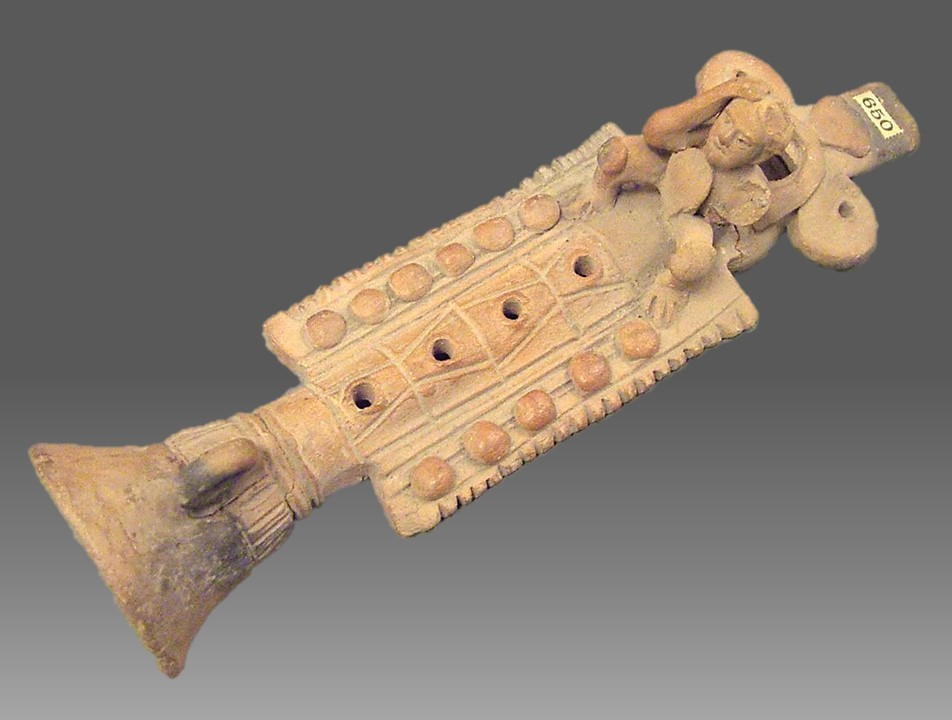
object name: pottery flute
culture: mexican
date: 1801-1900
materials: clay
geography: mexico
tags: human figures